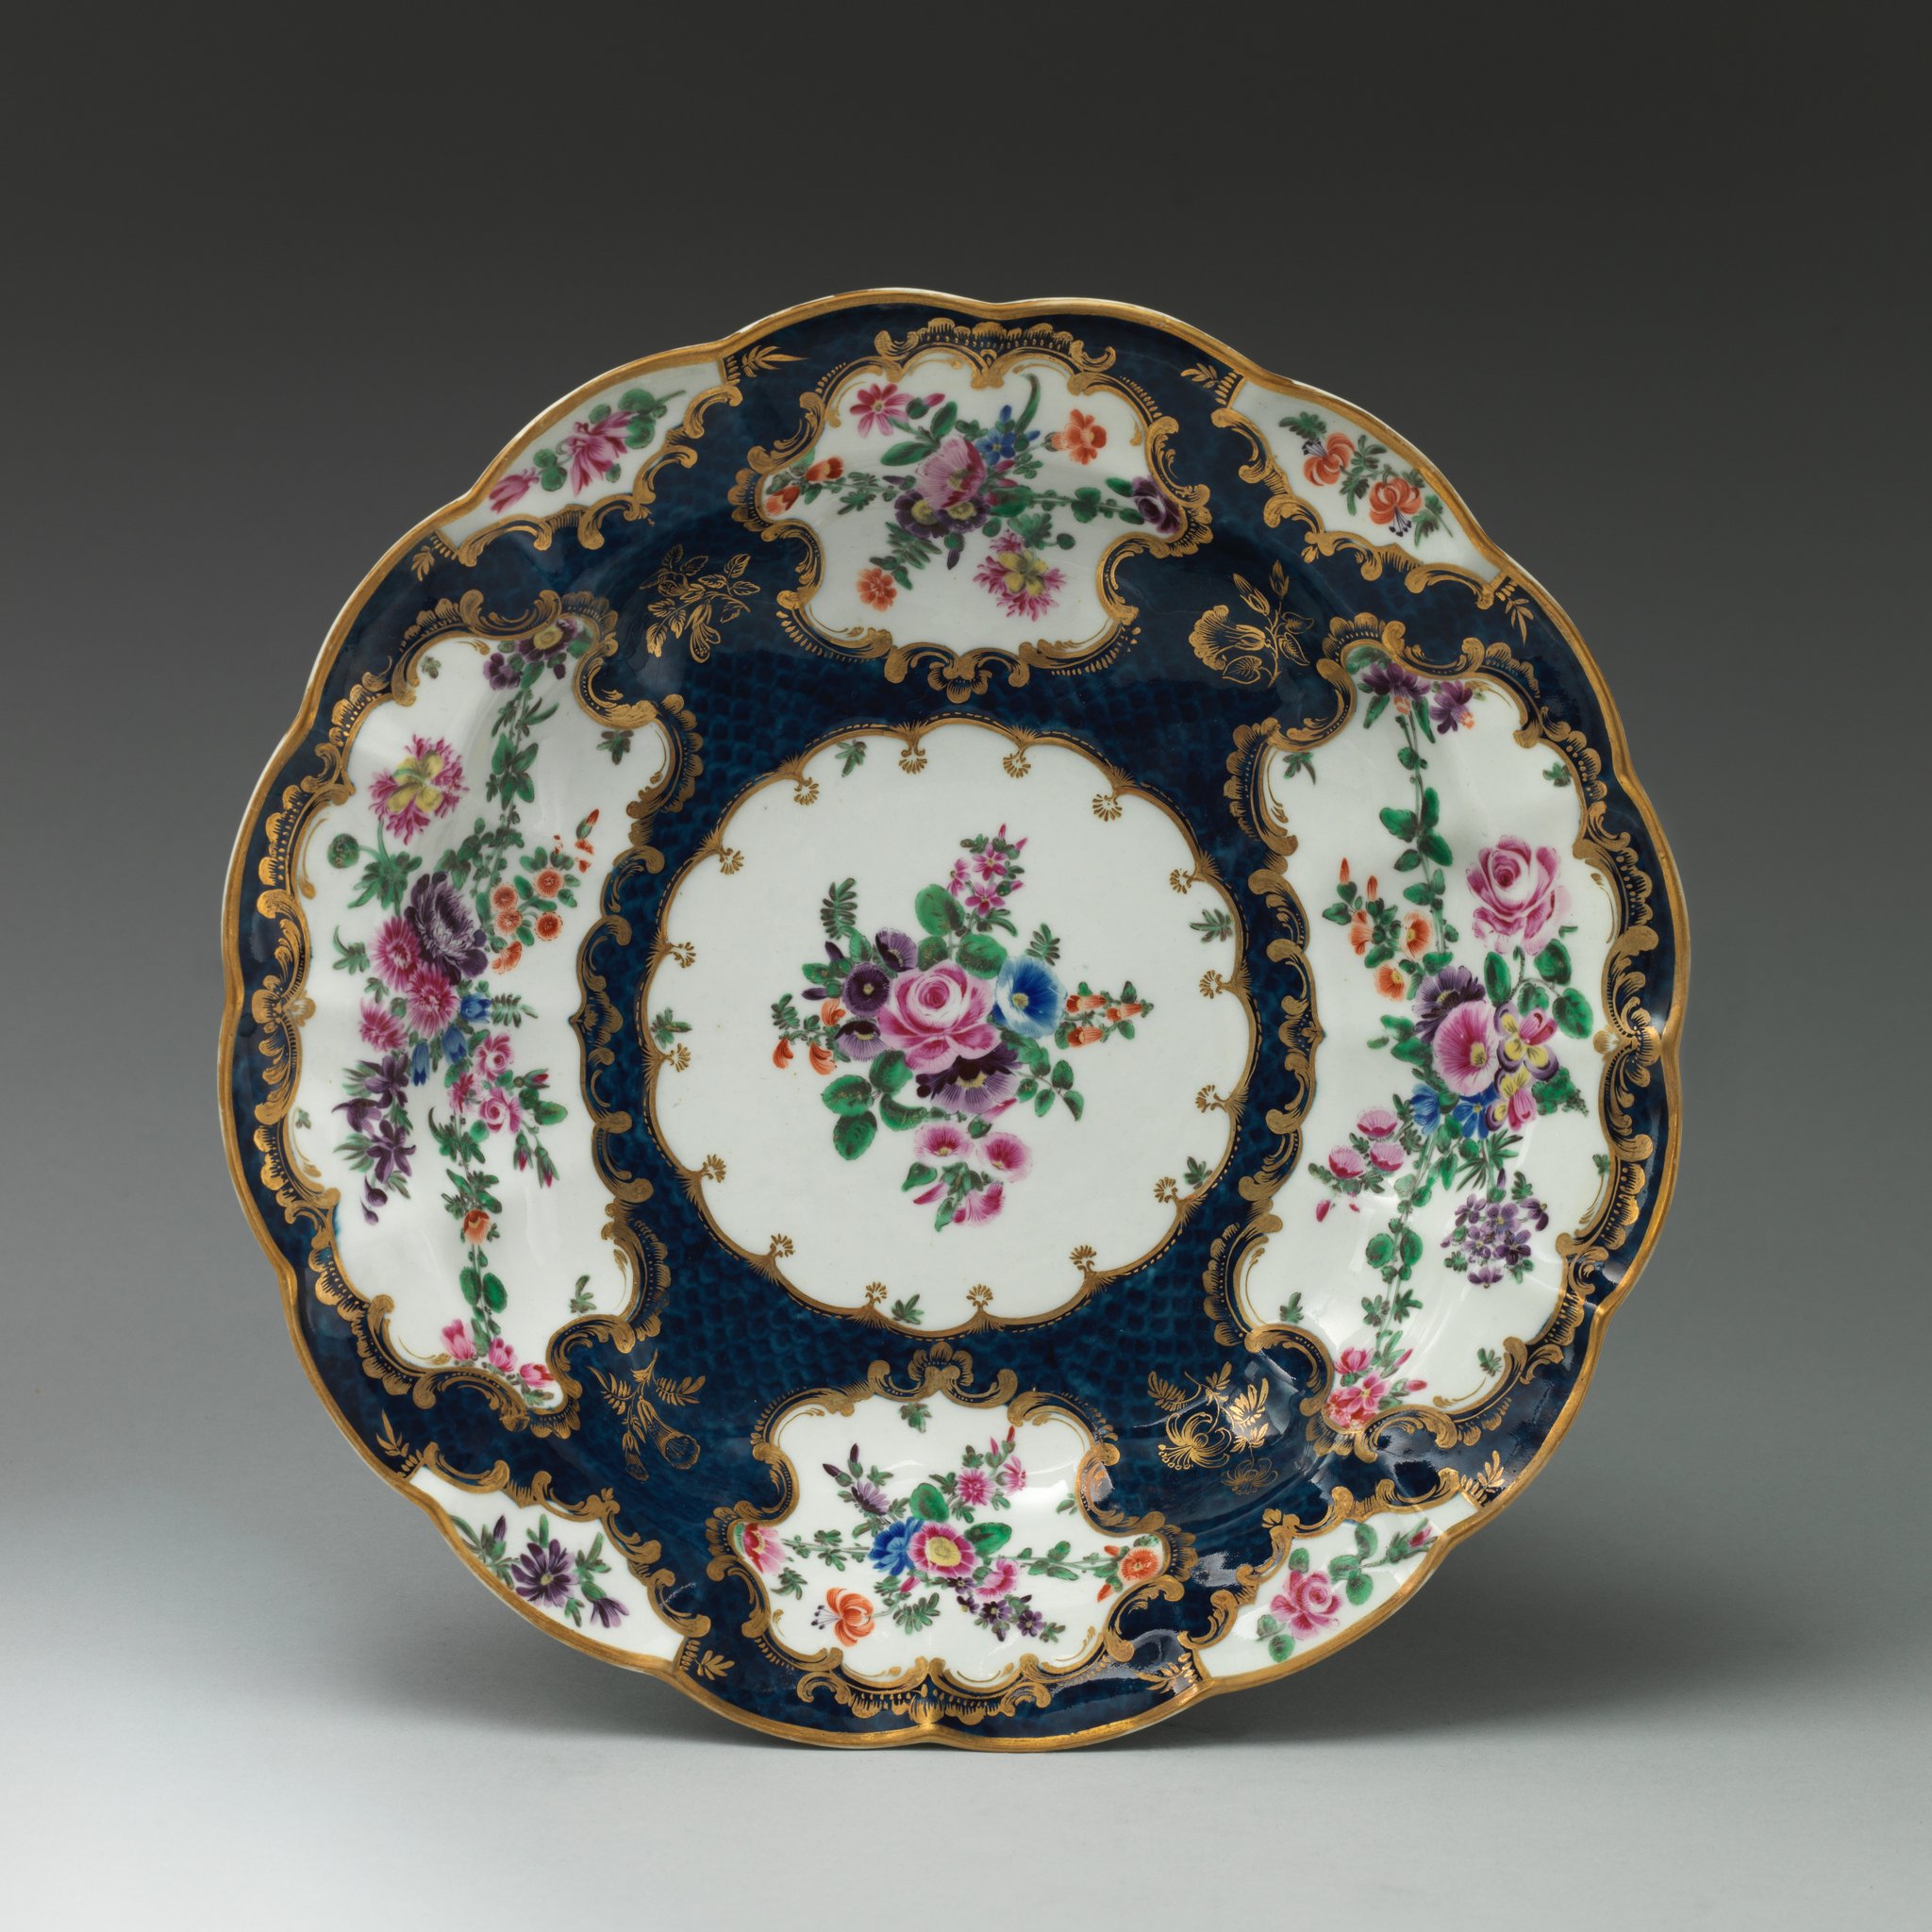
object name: dish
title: Dish (one of a pair)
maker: worcester factory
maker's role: factory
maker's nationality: british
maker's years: 1751-2008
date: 1770-1775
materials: soft paste porcelain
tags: flowers